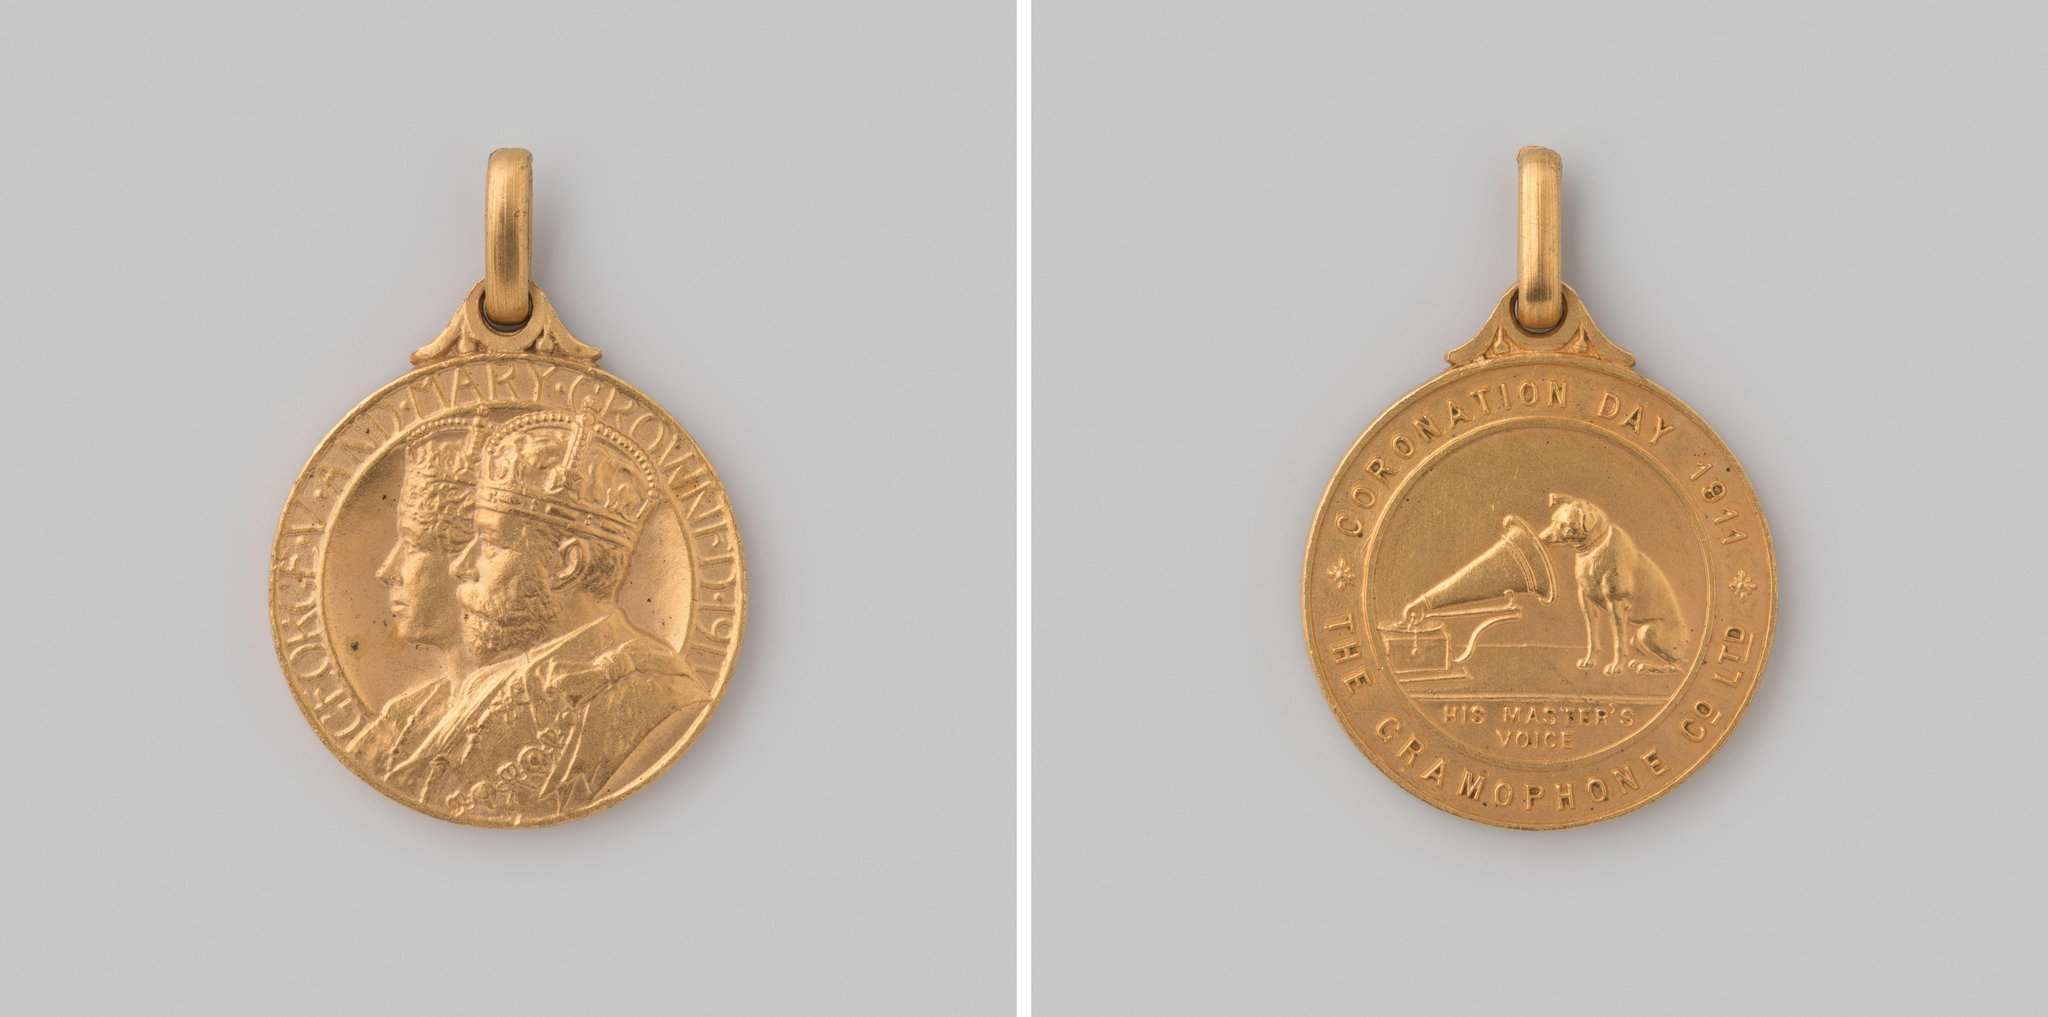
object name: history medal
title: Kroning van Koning George V en Koningin Mary van Engeland - reclamepenning van grammofoonmaatschappij His Masters Voice 1911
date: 1911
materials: brass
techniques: striking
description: Vergulde penning met oog en platte draagring, op de voorzijde de geconjugeerde borstbeelden van Mary en George met omschrift, op de keerzijde grammofoon en hond met afsnedetekst en omschrift.